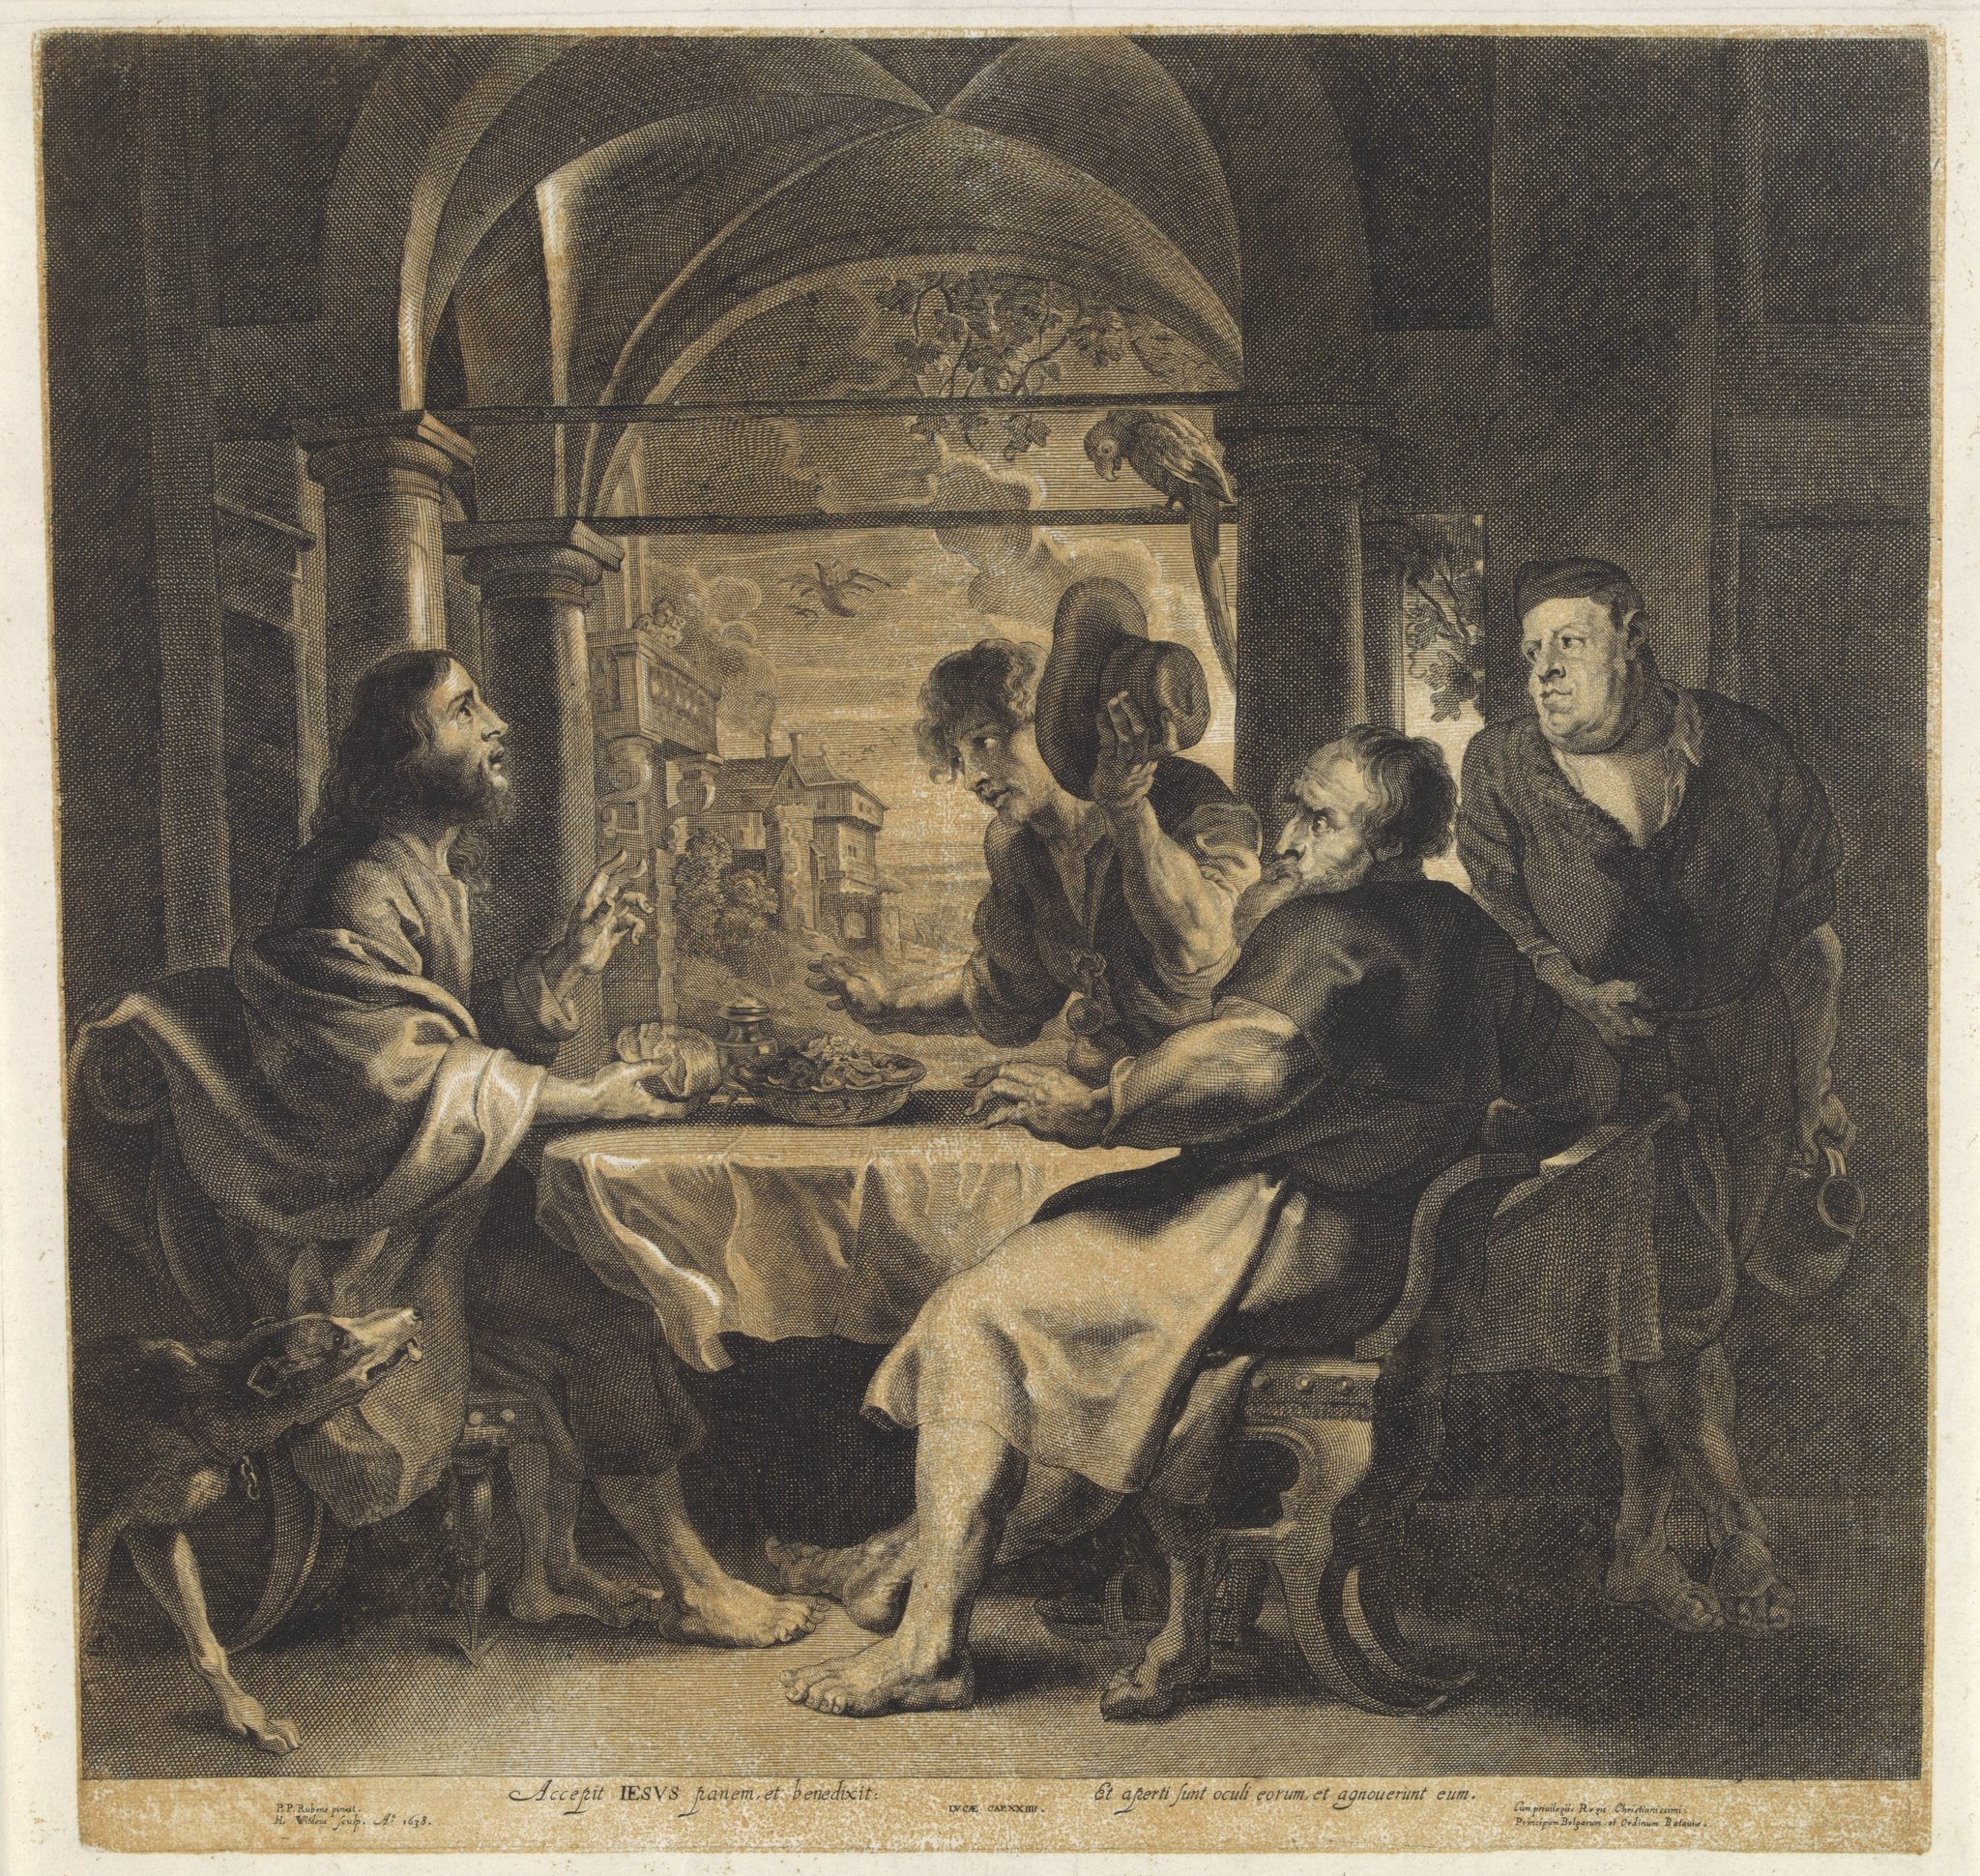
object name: print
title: Maaltijd in Emmaüs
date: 1638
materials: paper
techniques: engraving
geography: antwerp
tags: flying mammals: bat, the supper at emmaus: christ is recognized while blessing or breaking the bread, ornamental birds: parrot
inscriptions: collector's mark: Lugt 240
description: Christus en twee apostelen zitten rond een tafel in een herberg. Christus breekt het brood en maakt zo zijn identiteit bekend. De apostelen reageren geschokt. Boven de tafel een papegaai. Op de achtergrond een landschap en een vleermuis die door de lucht vliegt. In de marge een Bijbelcitaat uit Luc. 24 in het Latijn.